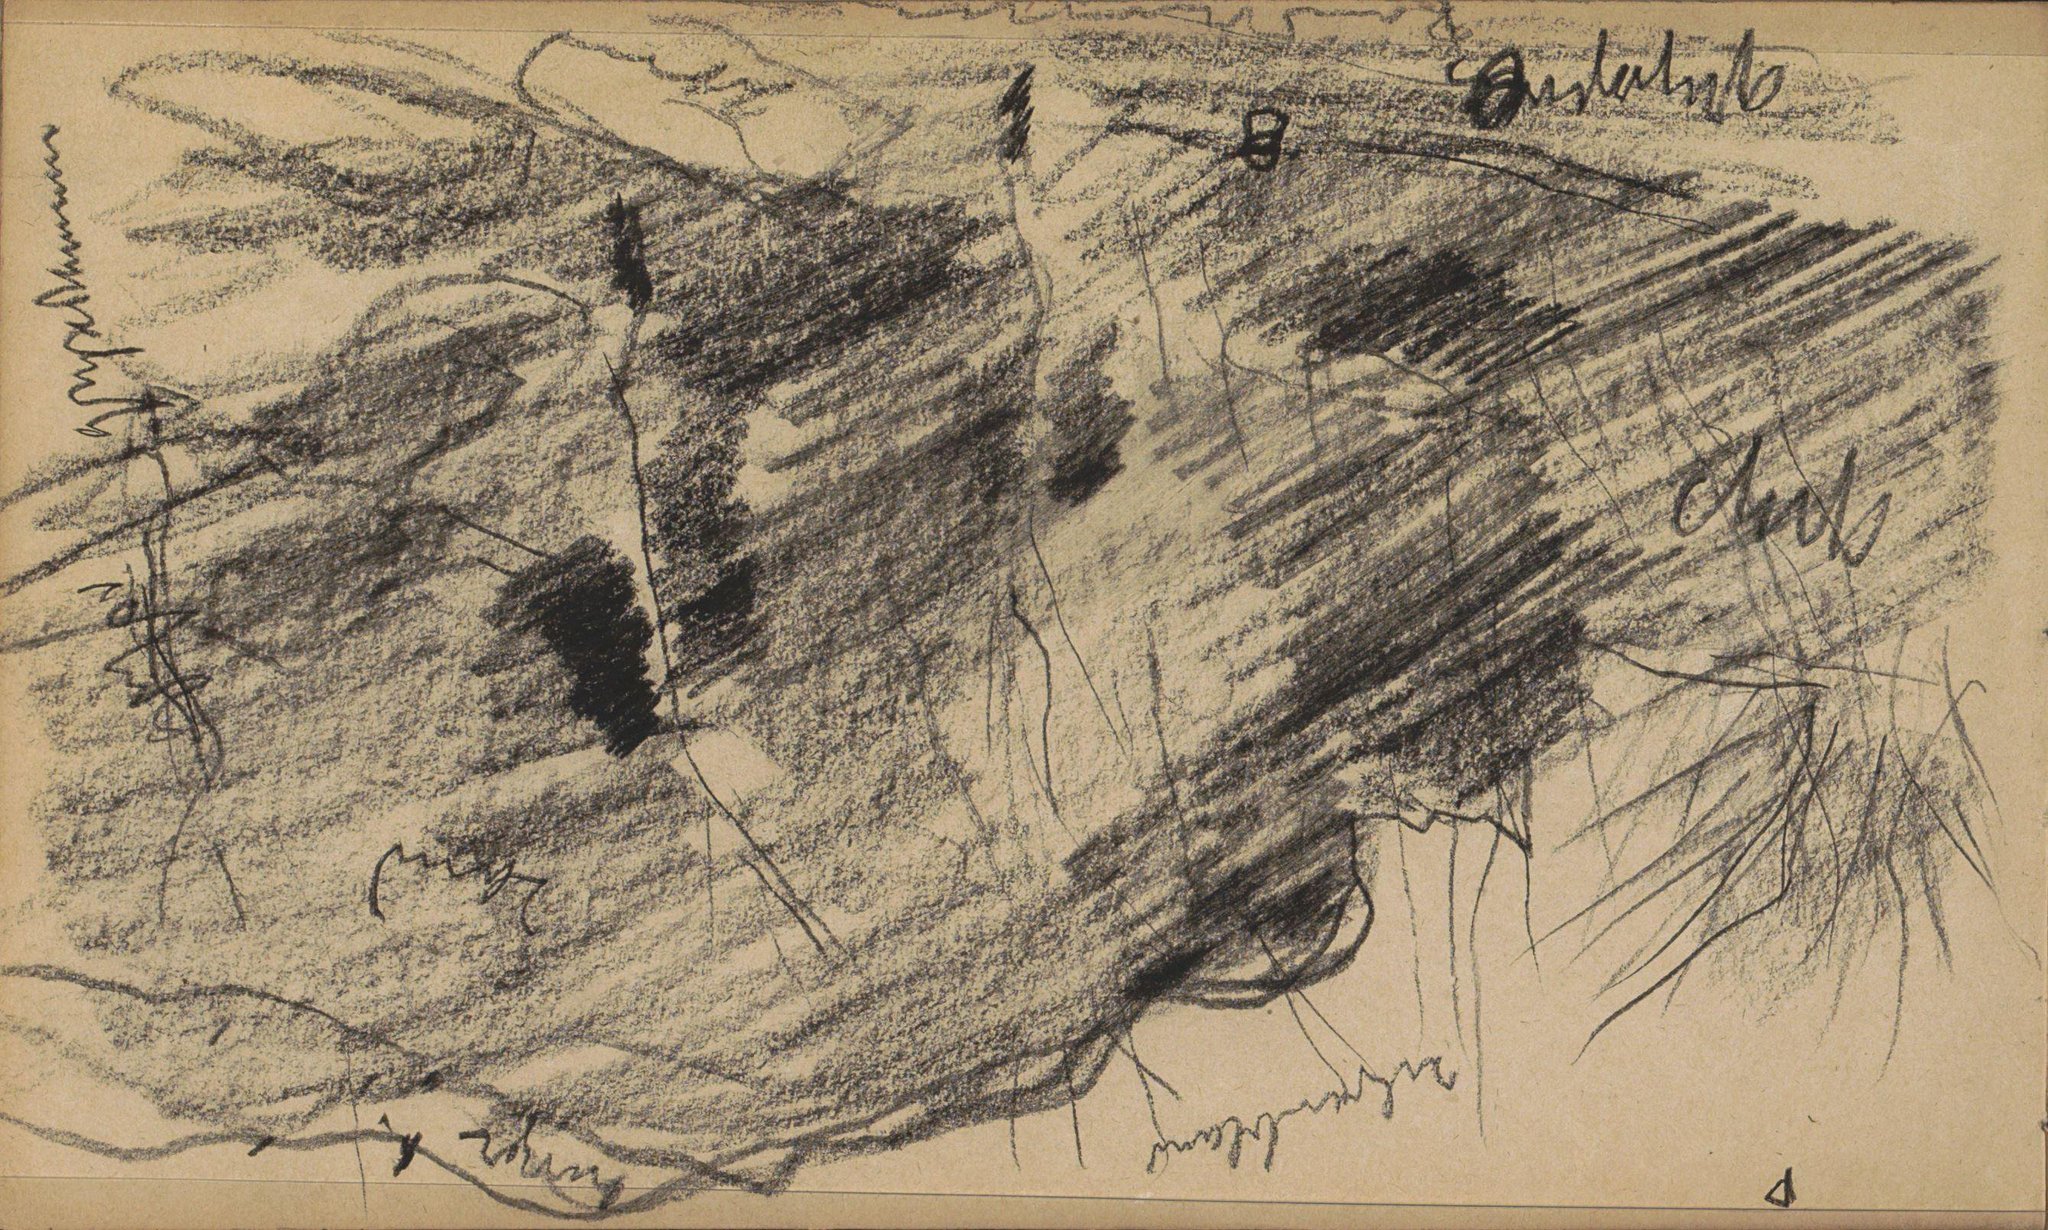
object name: sketchbook leaf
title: Zandheuvel, mogelijk een duin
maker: willem witsen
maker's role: draughtsman, painter, print maker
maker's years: 1860-1923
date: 1888-1891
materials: chalk, paper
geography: amsterdam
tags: dunes (sea not visible); in the dunes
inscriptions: kleurnotitie, handgeschreven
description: Pagina 16 uit een schetsboek met 27 bladen.